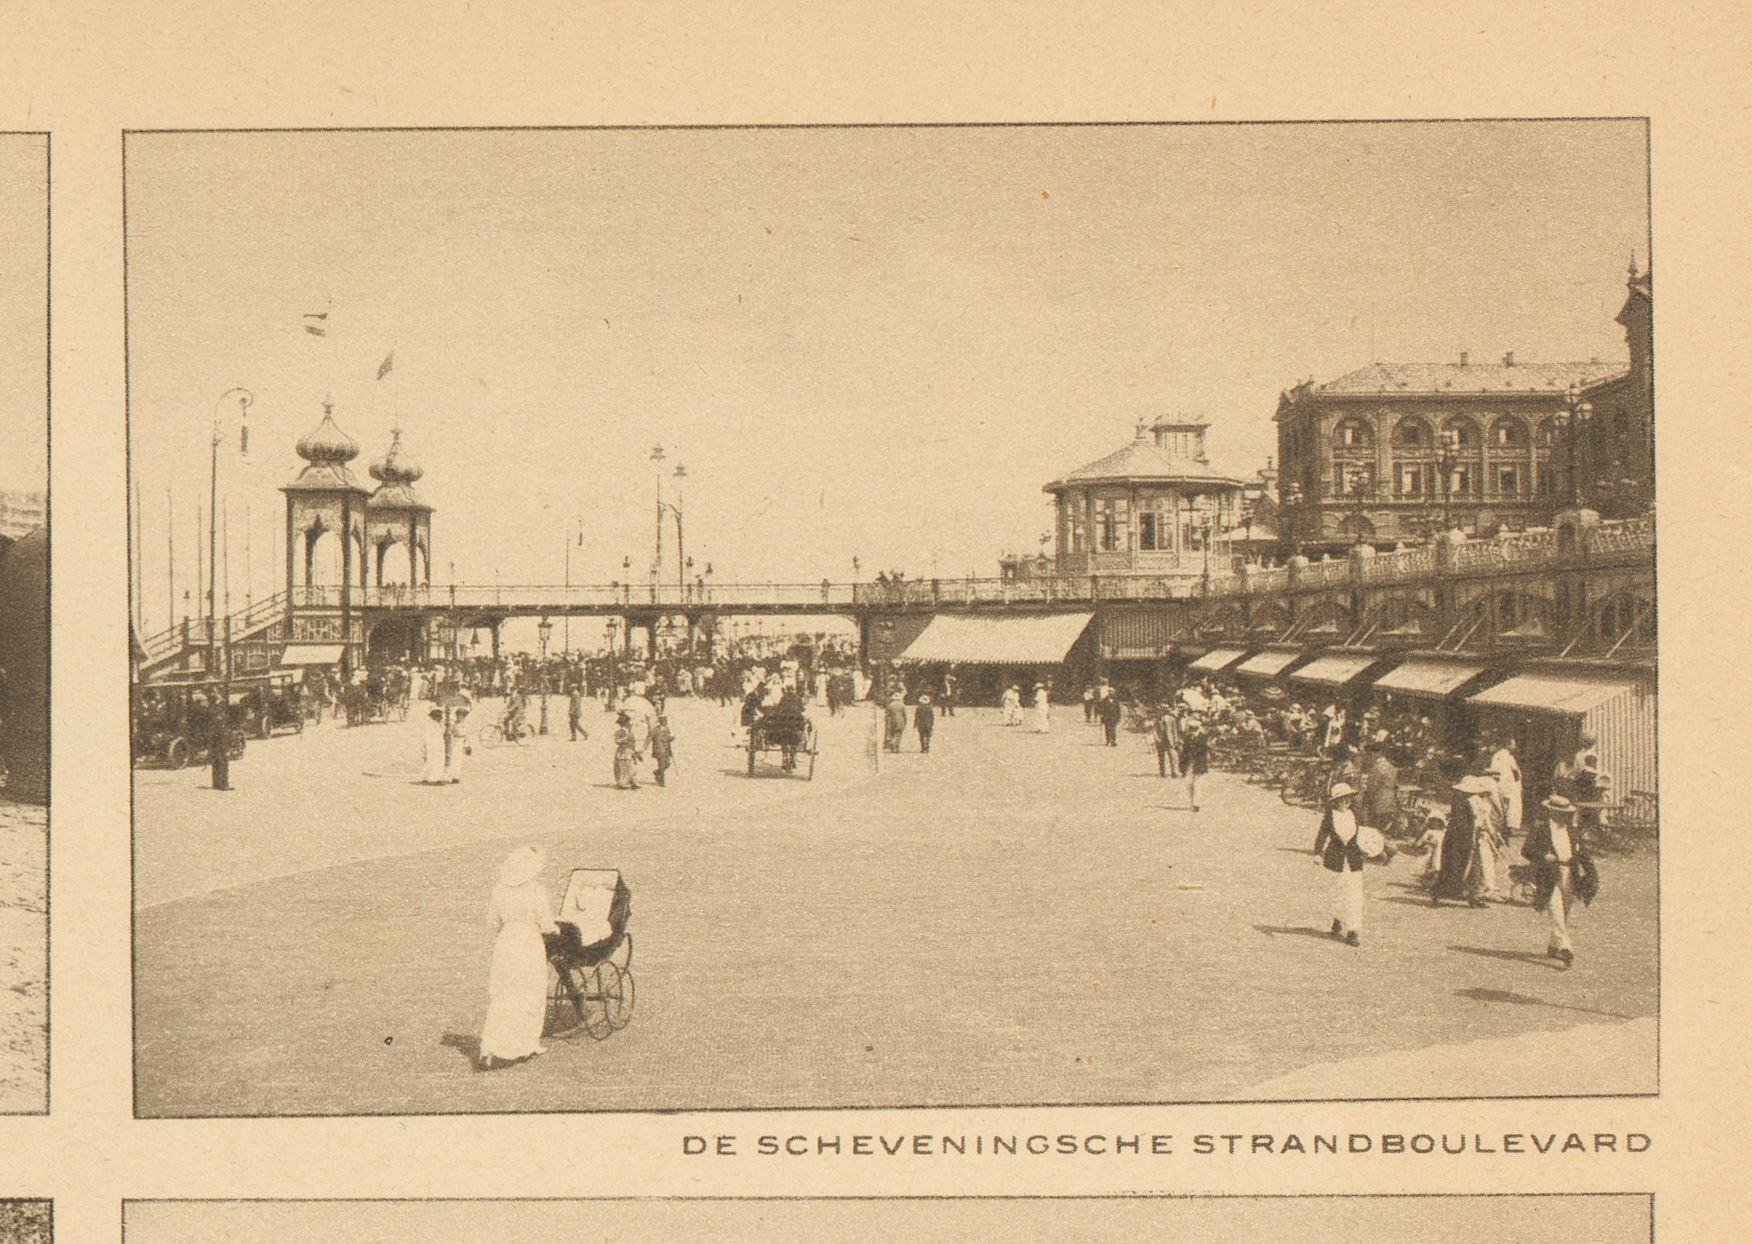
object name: album leaf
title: Gezicht op de boulevard van Scheveningen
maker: Anonymous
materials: paper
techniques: rotogravure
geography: leiden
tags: avenue, boulevard, promenade, esplanade (+ city(-scape) with figures, staffage)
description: Deze prent maakt deel uit van een album.